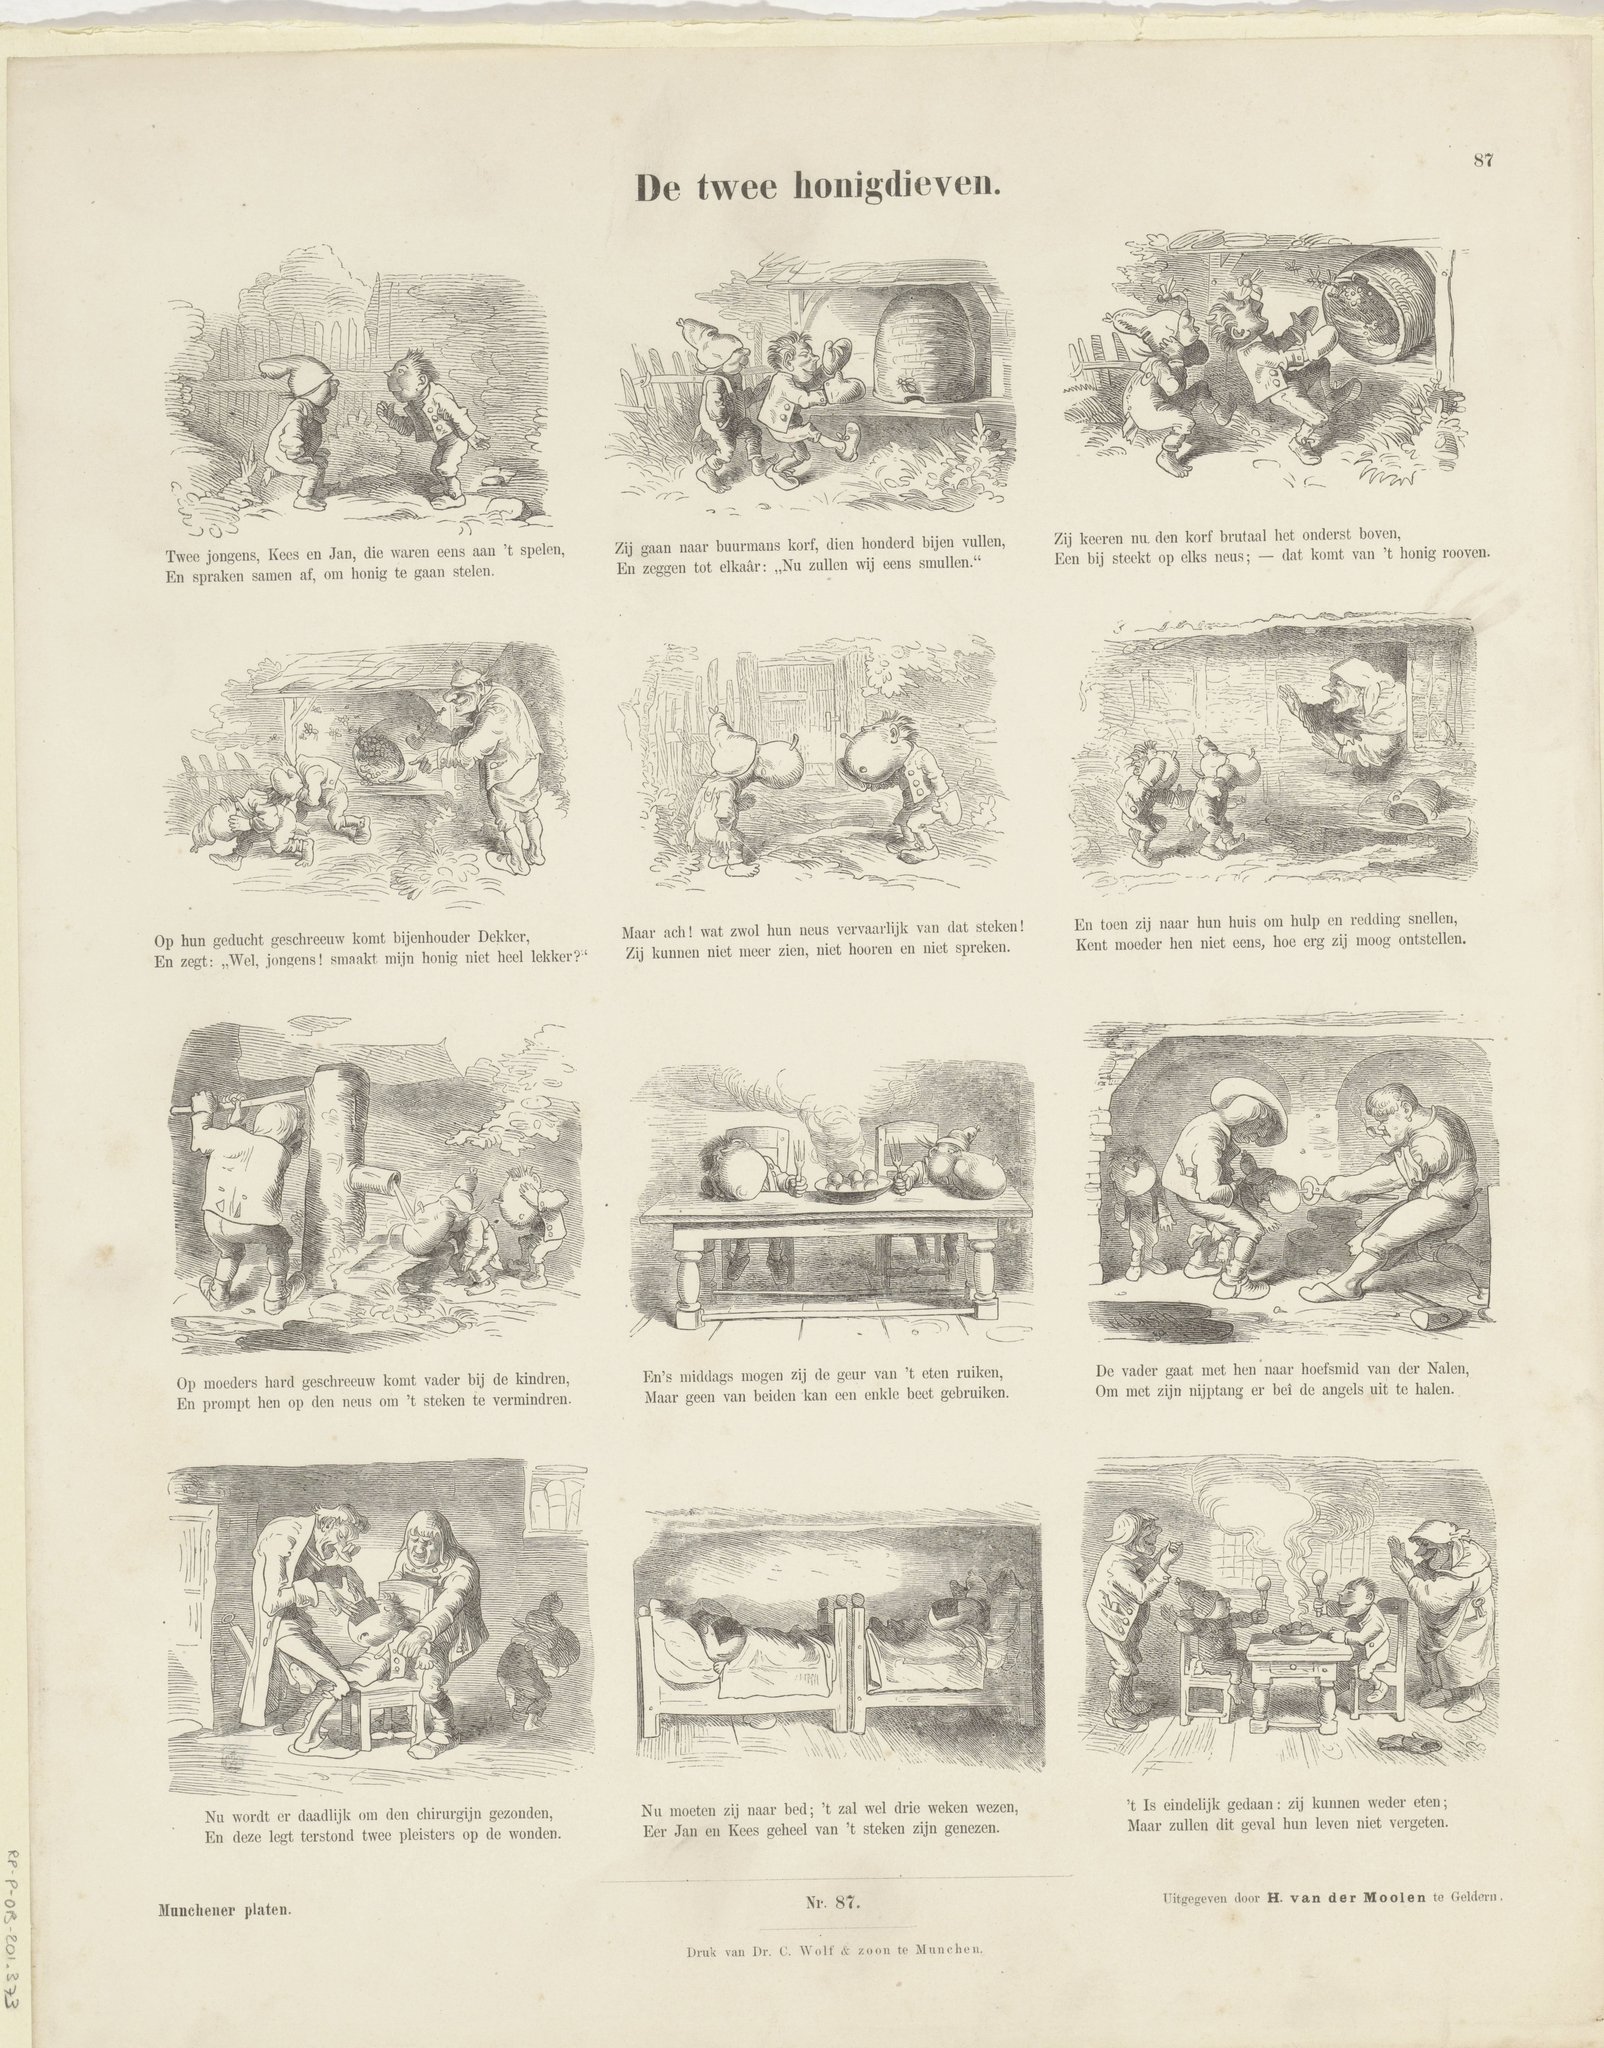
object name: print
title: Munchener platen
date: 1860-1868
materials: paper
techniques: letterpress printing, engraving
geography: munich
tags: bee-hive, tales and fairy tales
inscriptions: collector's mark: Lugt 2760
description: Blad met 12 voorstellingen uit het het verhaal van de twee deugnieten Kees en Jan die honing stelen en vervolgens gestoken worden door bijen. Onder elke afbeelding een tweeregelig vers. Genummerd midden onder: Nro. 87. Genummerd rechtsboven: 87.